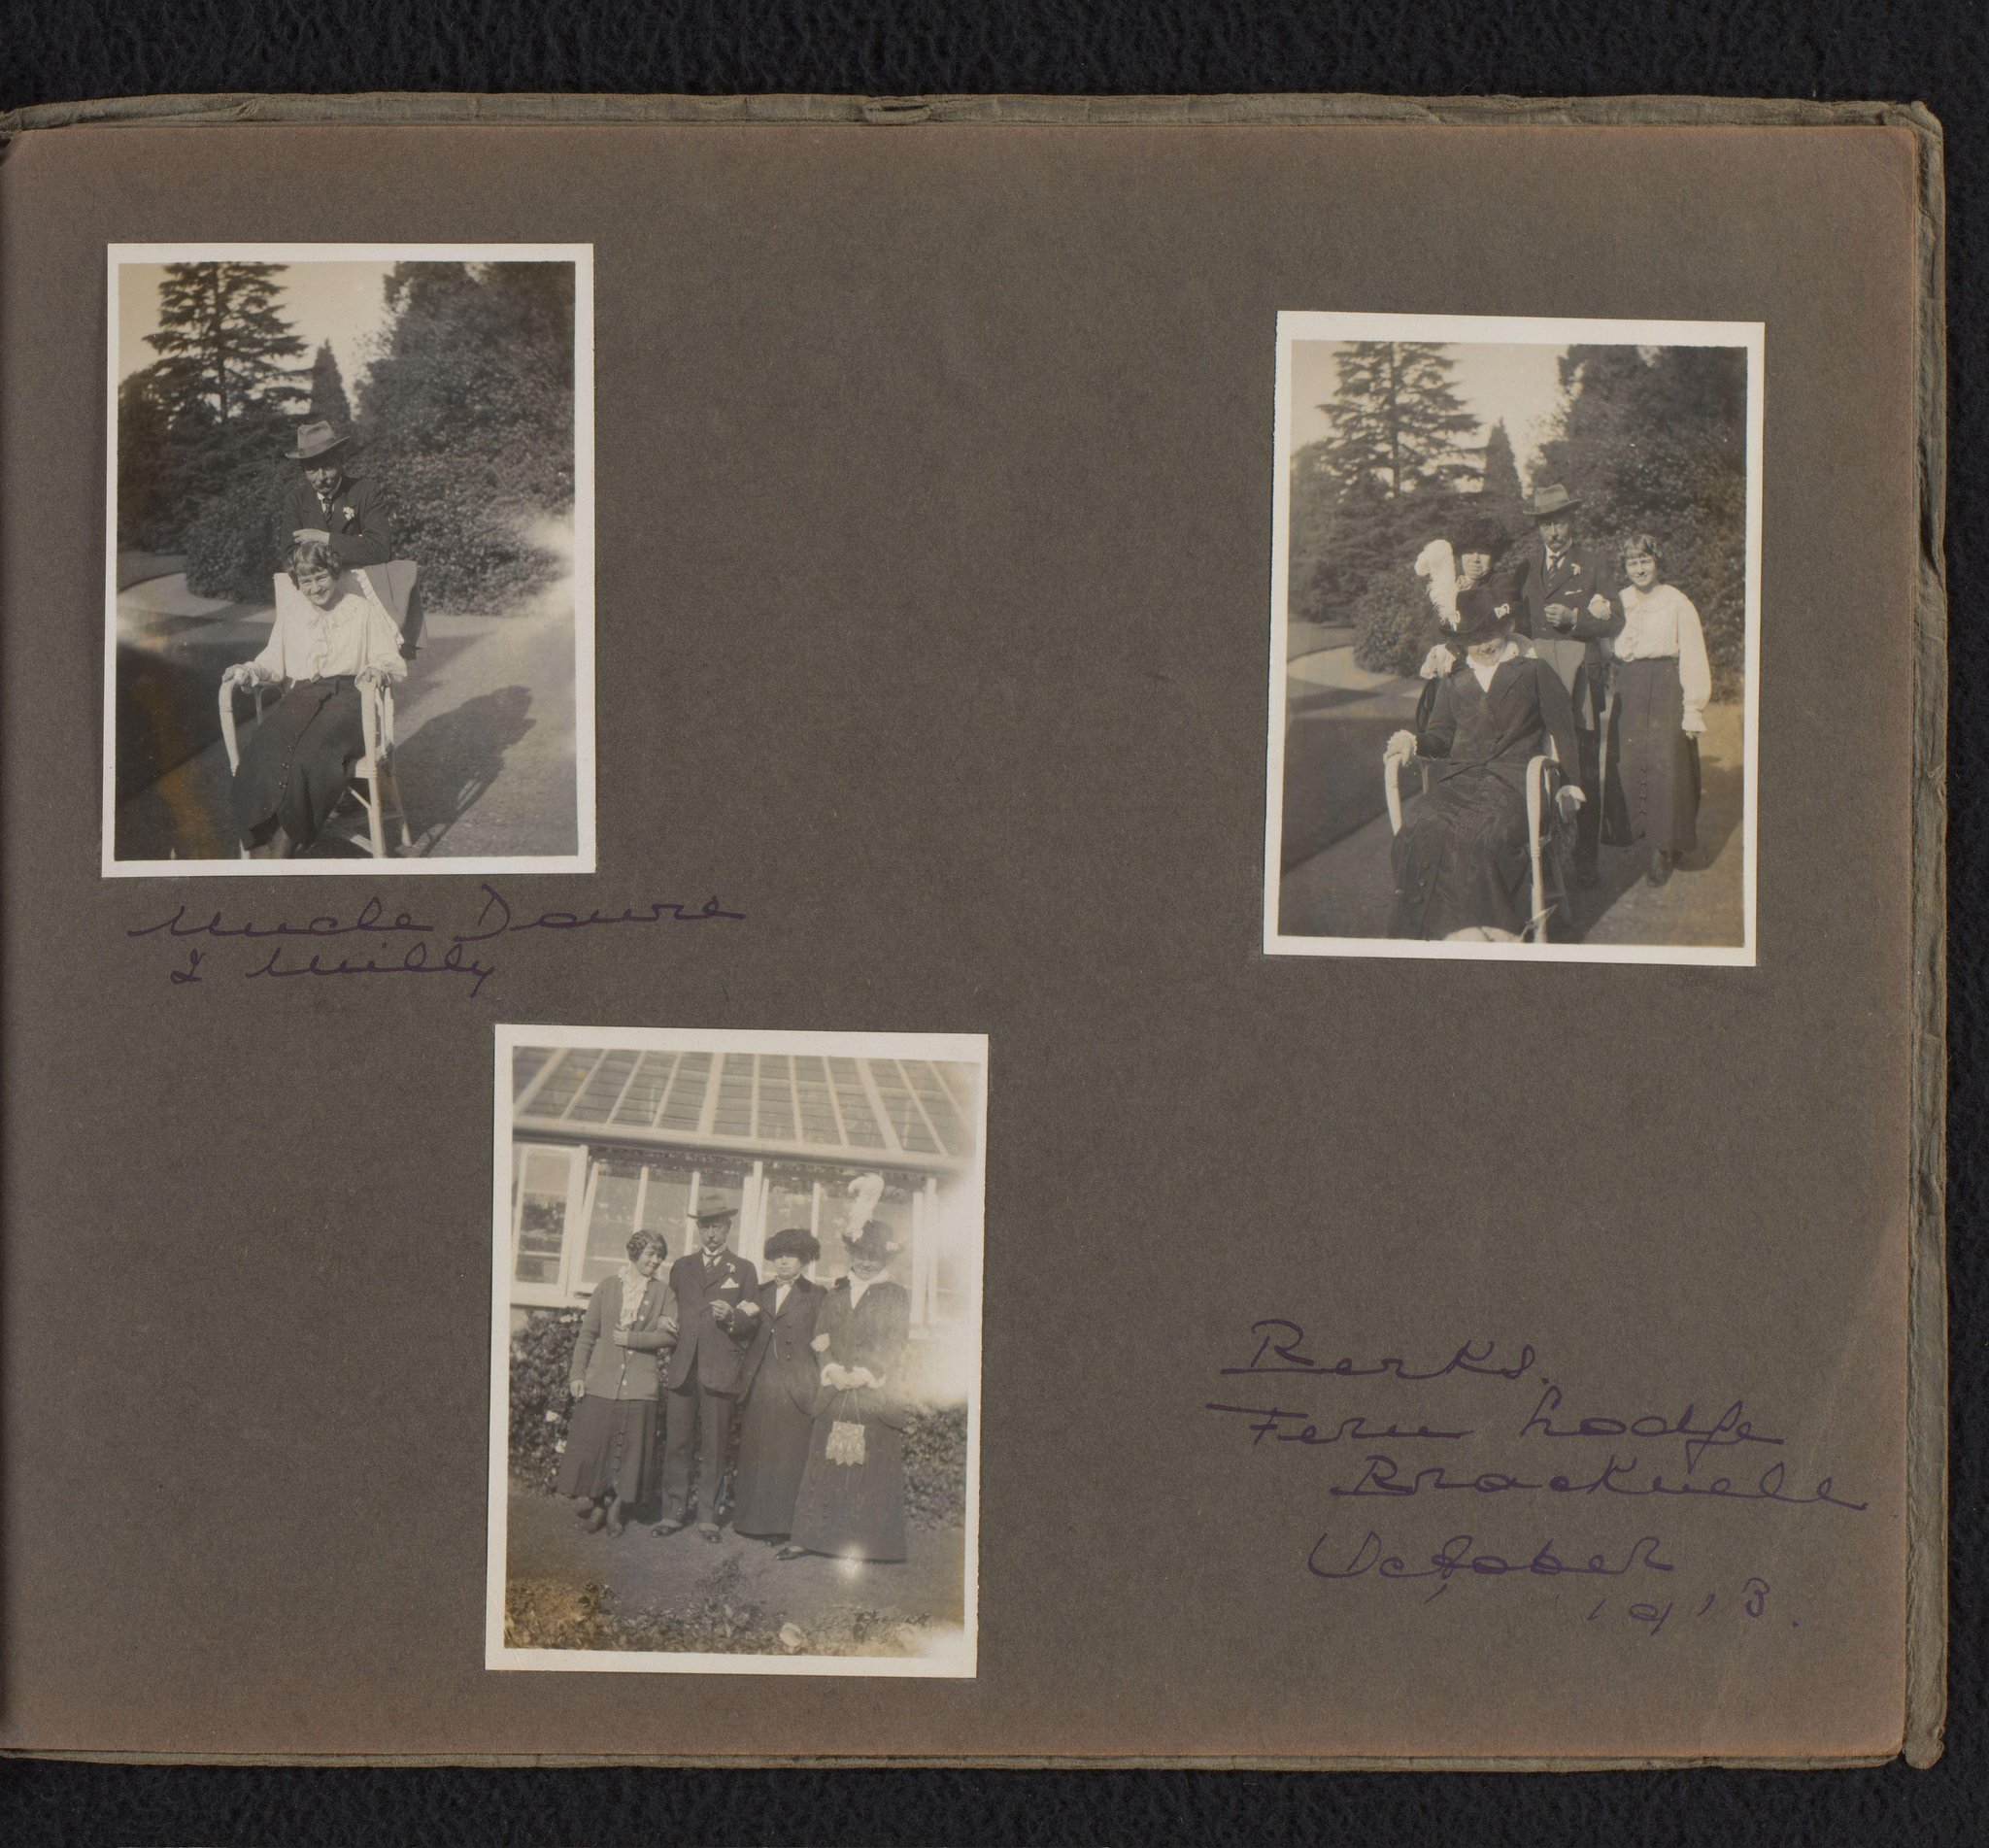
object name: album leaf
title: Willy Onnen met haar oom en tante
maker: Anonymous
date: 1910-1913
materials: paper, cardboard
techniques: gelatin silver print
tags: batavia, emilie albertina onnen (milly), uncles, aunts (third degree family relationships)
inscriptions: inscription: ‘Uncle Da[...]/ & Willy/ Berks [?]/ Feru Lodje [?]/ Braekvelde’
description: Deze foto's zijn onderdeel van een album.